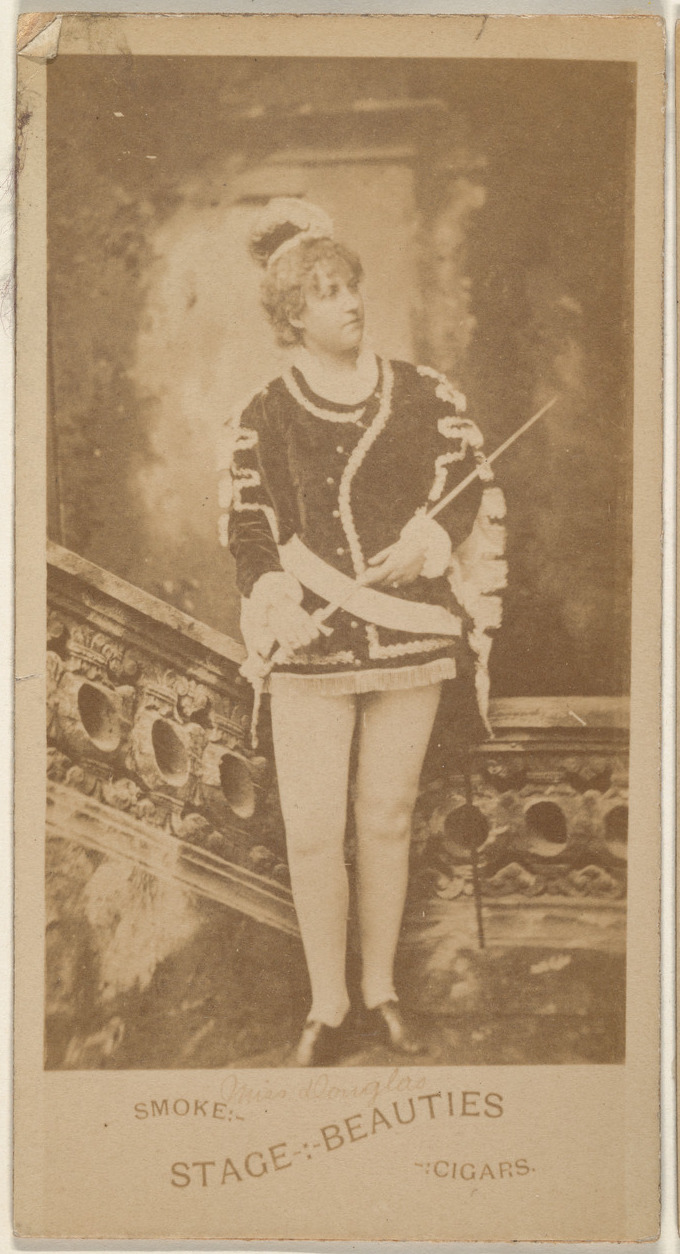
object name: photograph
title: Miss Douglas, from the Actresses series (N666) to promote Stage Beauties Cigars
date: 1888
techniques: albumen silver print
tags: portraits,women,actresses